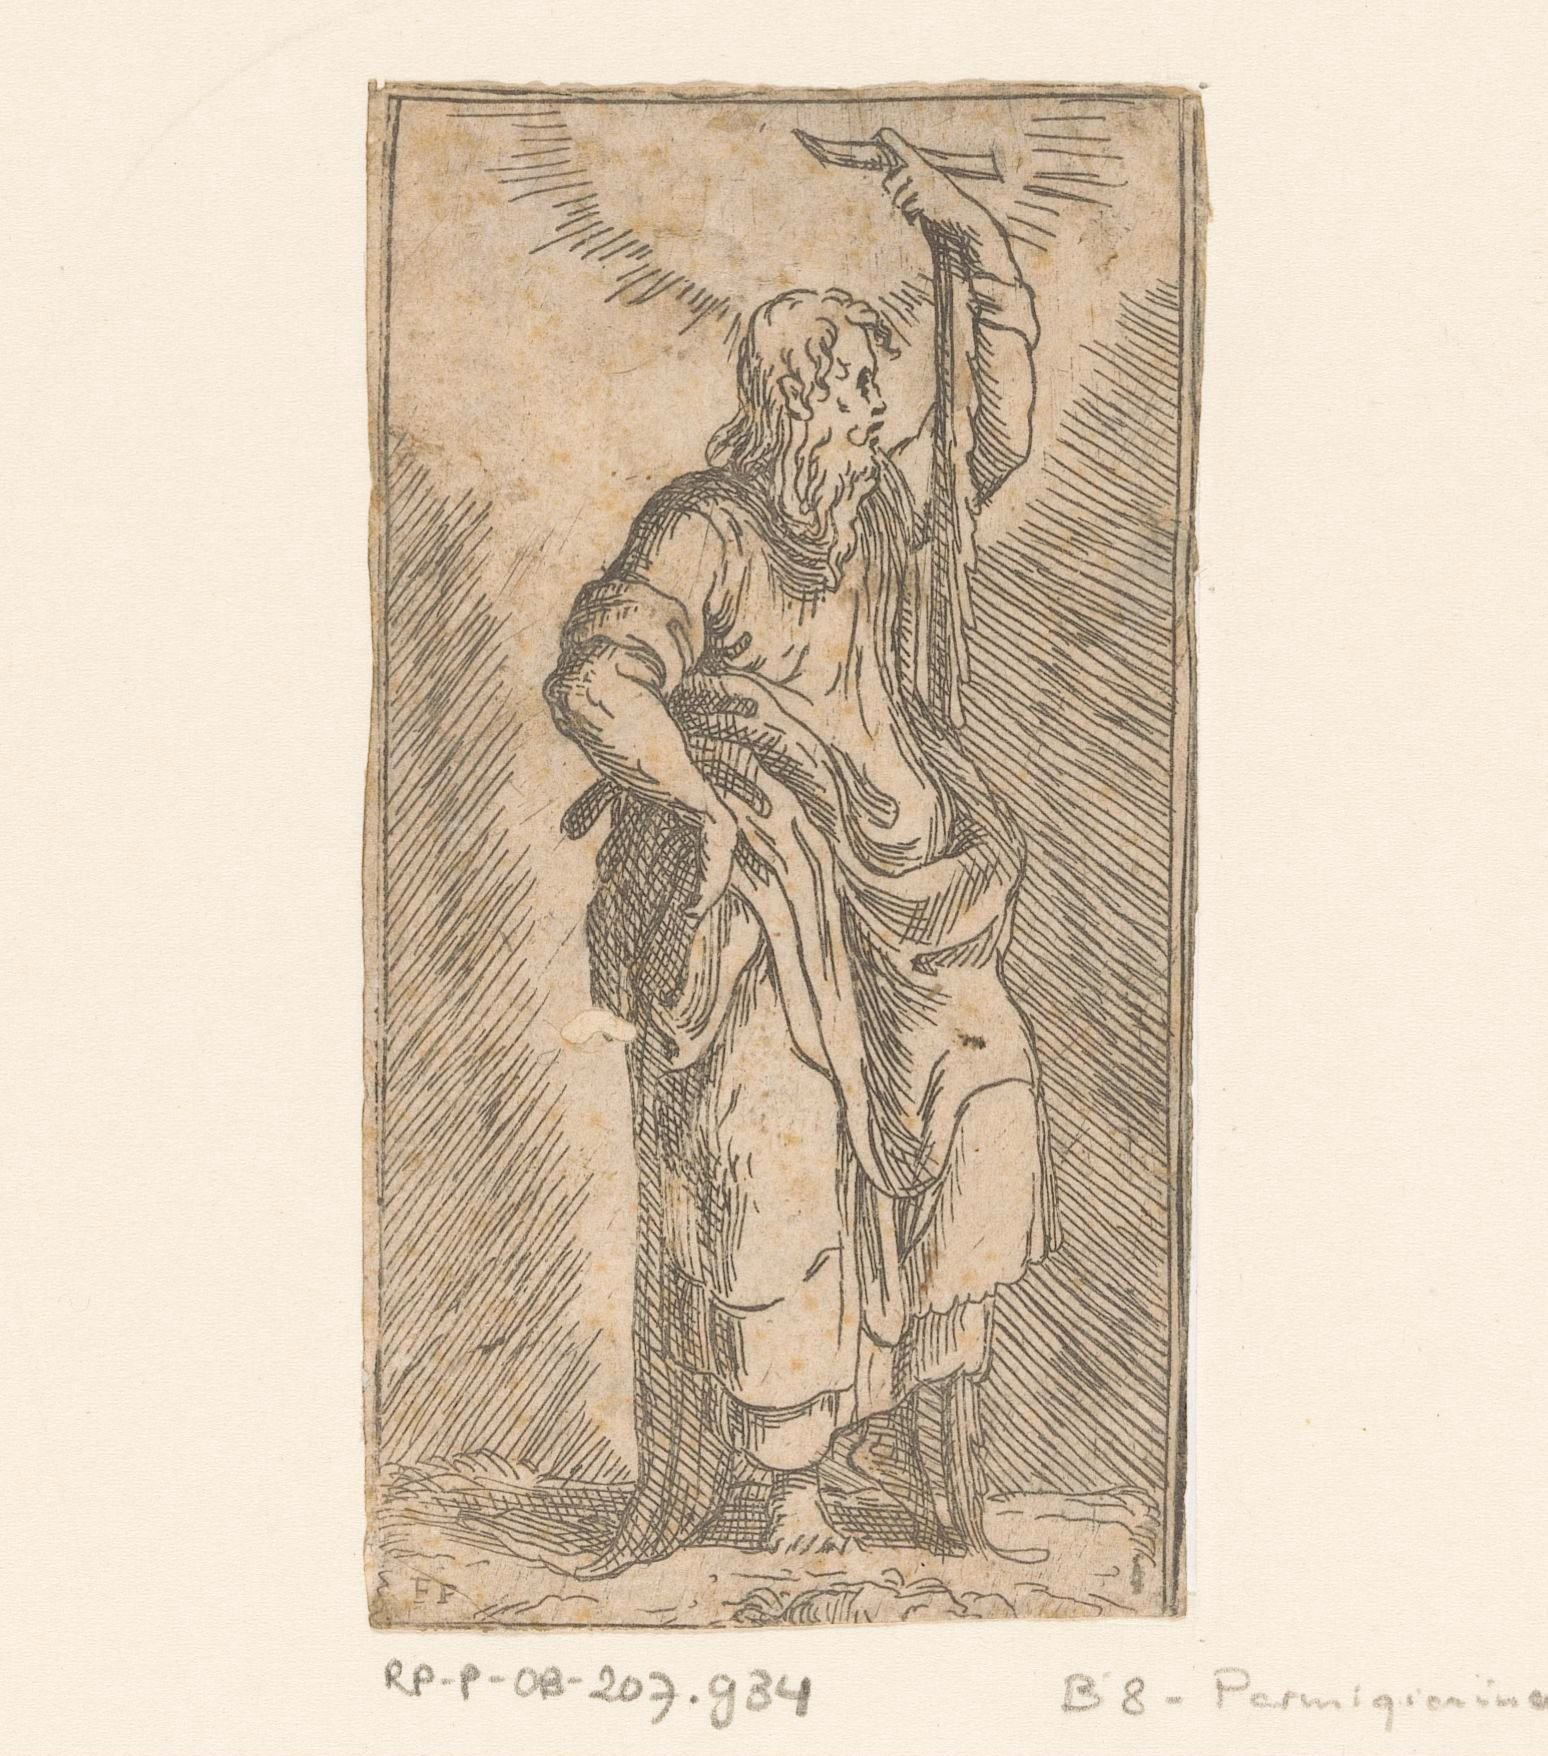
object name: print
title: De heilige Simon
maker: monogrammist fp (italië; 16e eeuw)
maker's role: print maker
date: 1500-1599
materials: paper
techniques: etching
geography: italy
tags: the apostle simon zelotes (or simon the canaanite); possible attributes: book, saw, scroll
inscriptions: collector's mark: ‘RIJKS / MUSM’, collector's mark: Lugt 2228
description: Deze prent maakt deel uit van een reeks van dertien prenten van Christus en de twaalf apostelen.